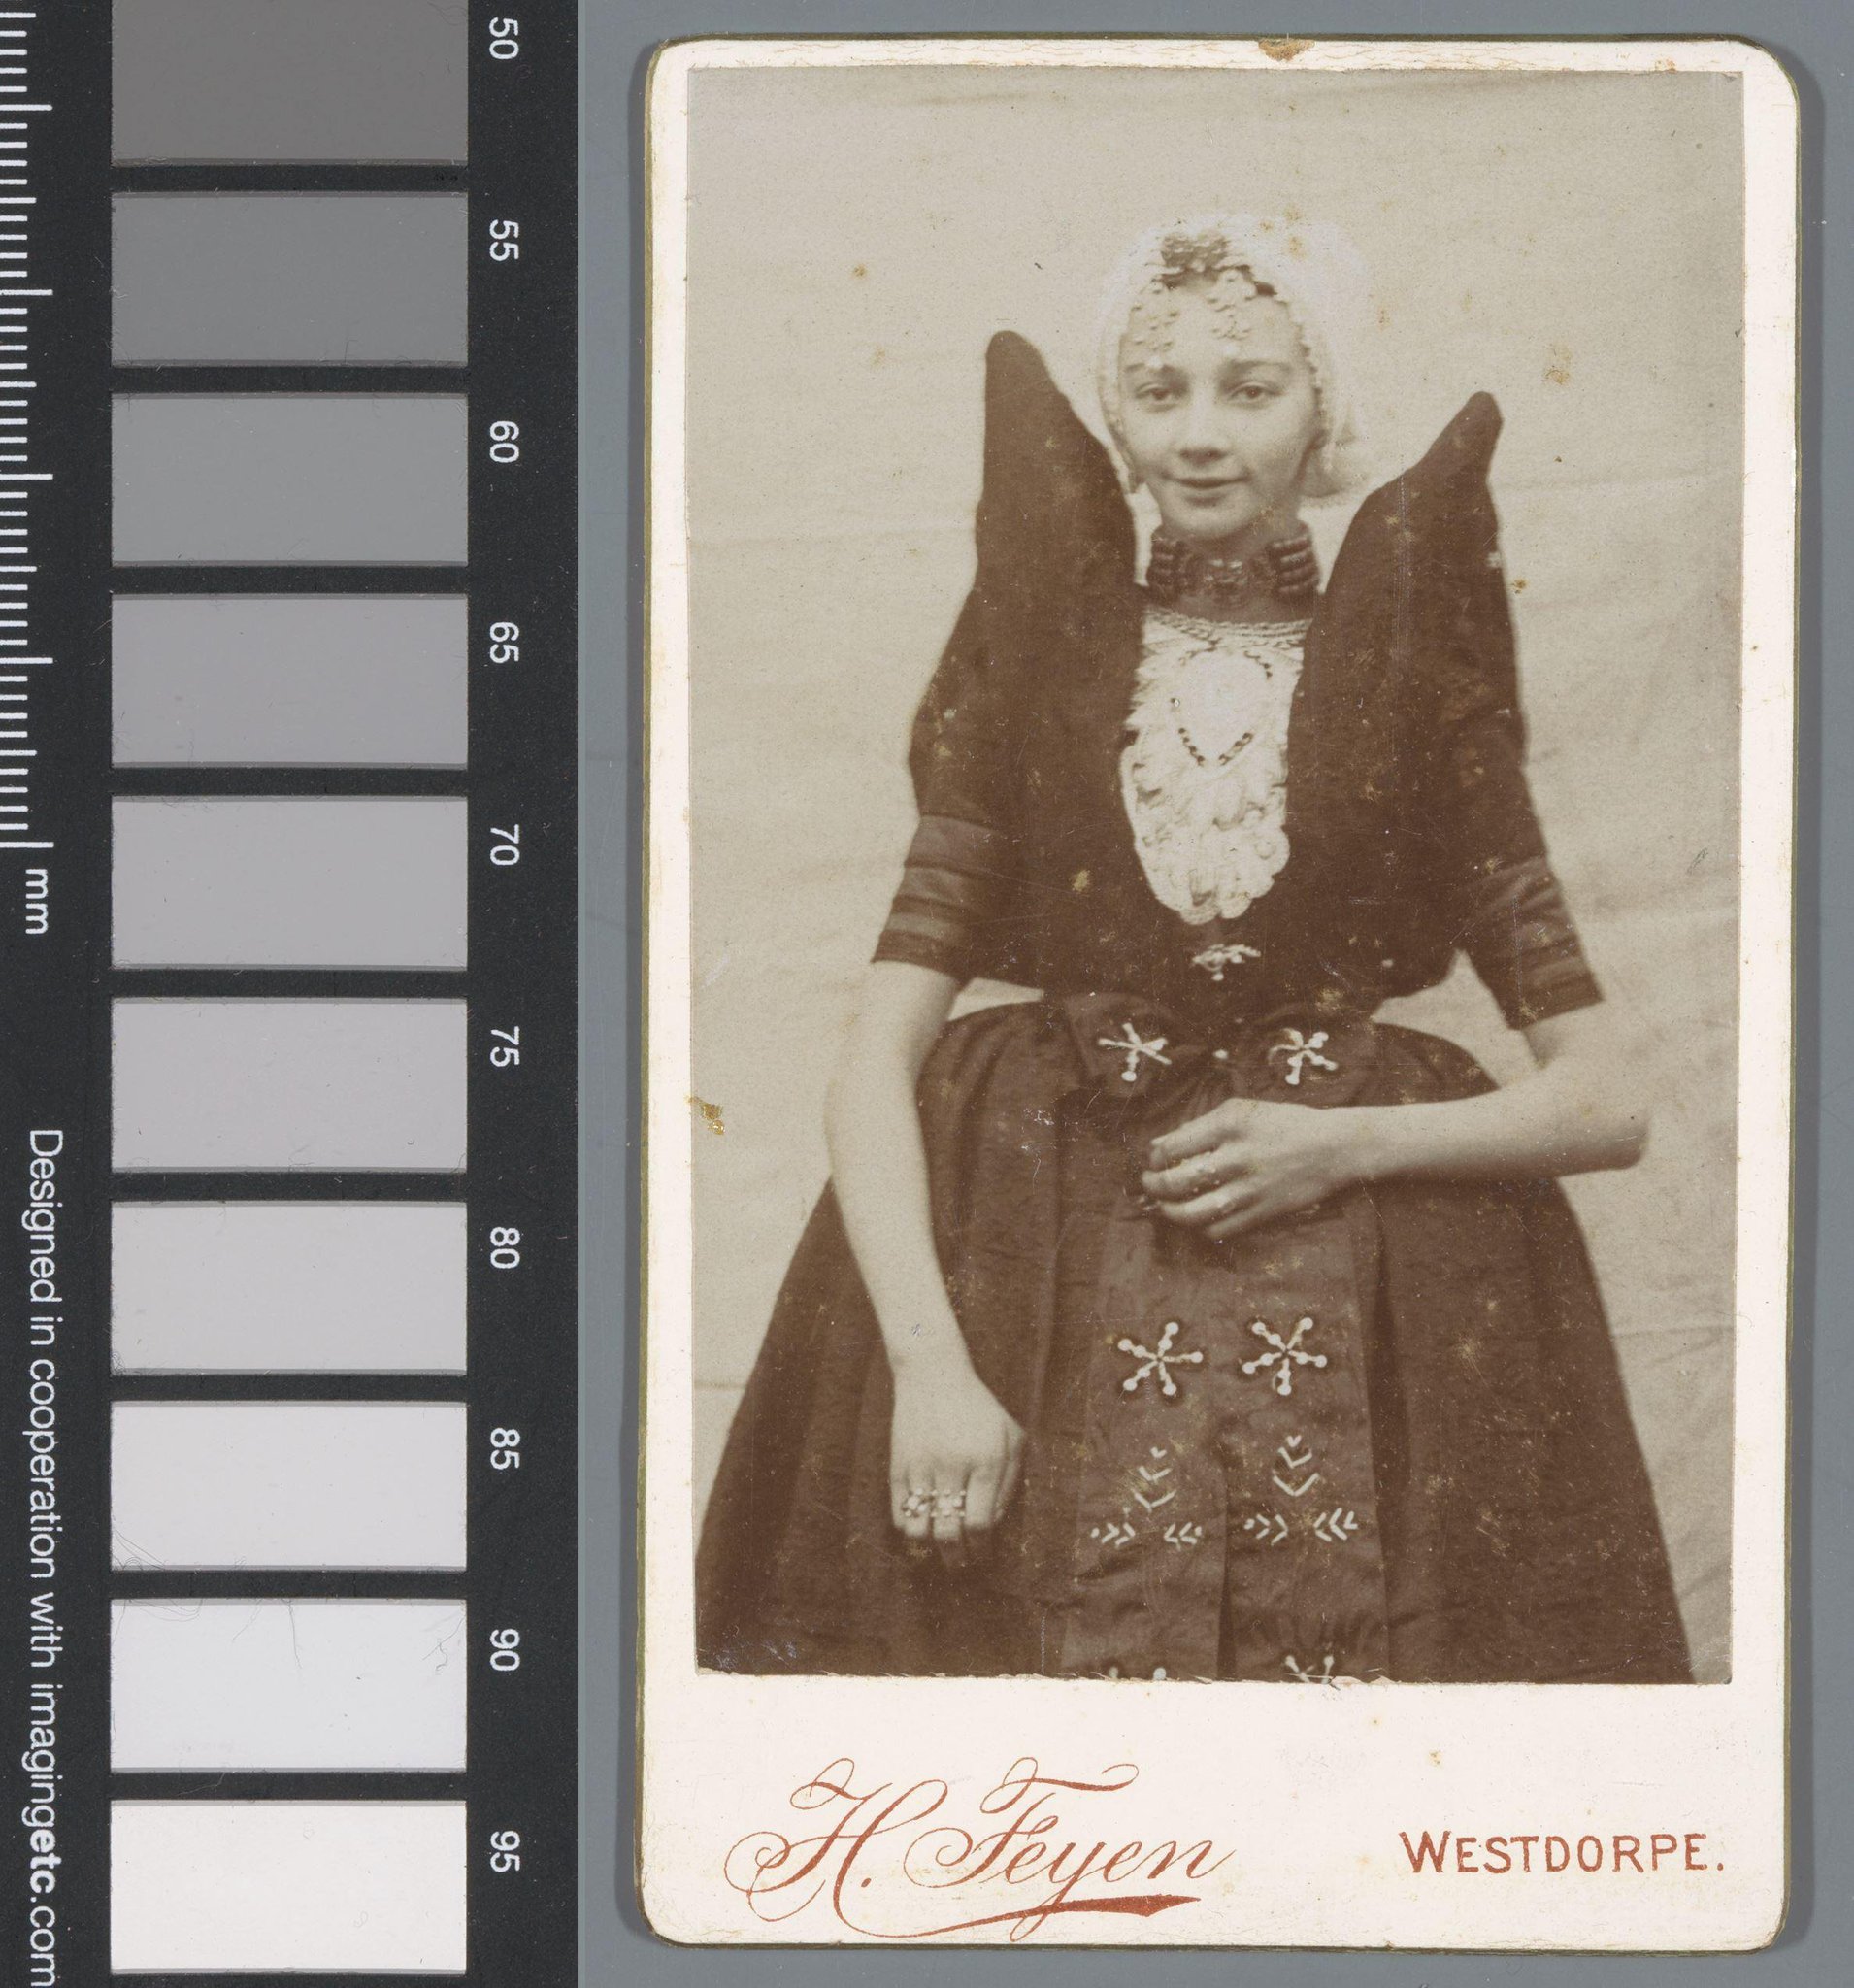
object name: photograph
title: Portret van een onbekende jonge vrouw in Zeeuwse klederdracht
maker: honoré feijen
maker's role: fotograaf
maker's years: 1873-1956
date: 1900-1914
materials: paper, cardboard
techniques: collodion silver print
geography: westdorpe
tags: adolescent, young woman, maiden, anonymous historical person portrayed, folk costume, regional costume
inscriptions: inscription: ‘Vergrootingen en reproductie/ clichés worden tot nabestellingen bewaard.’